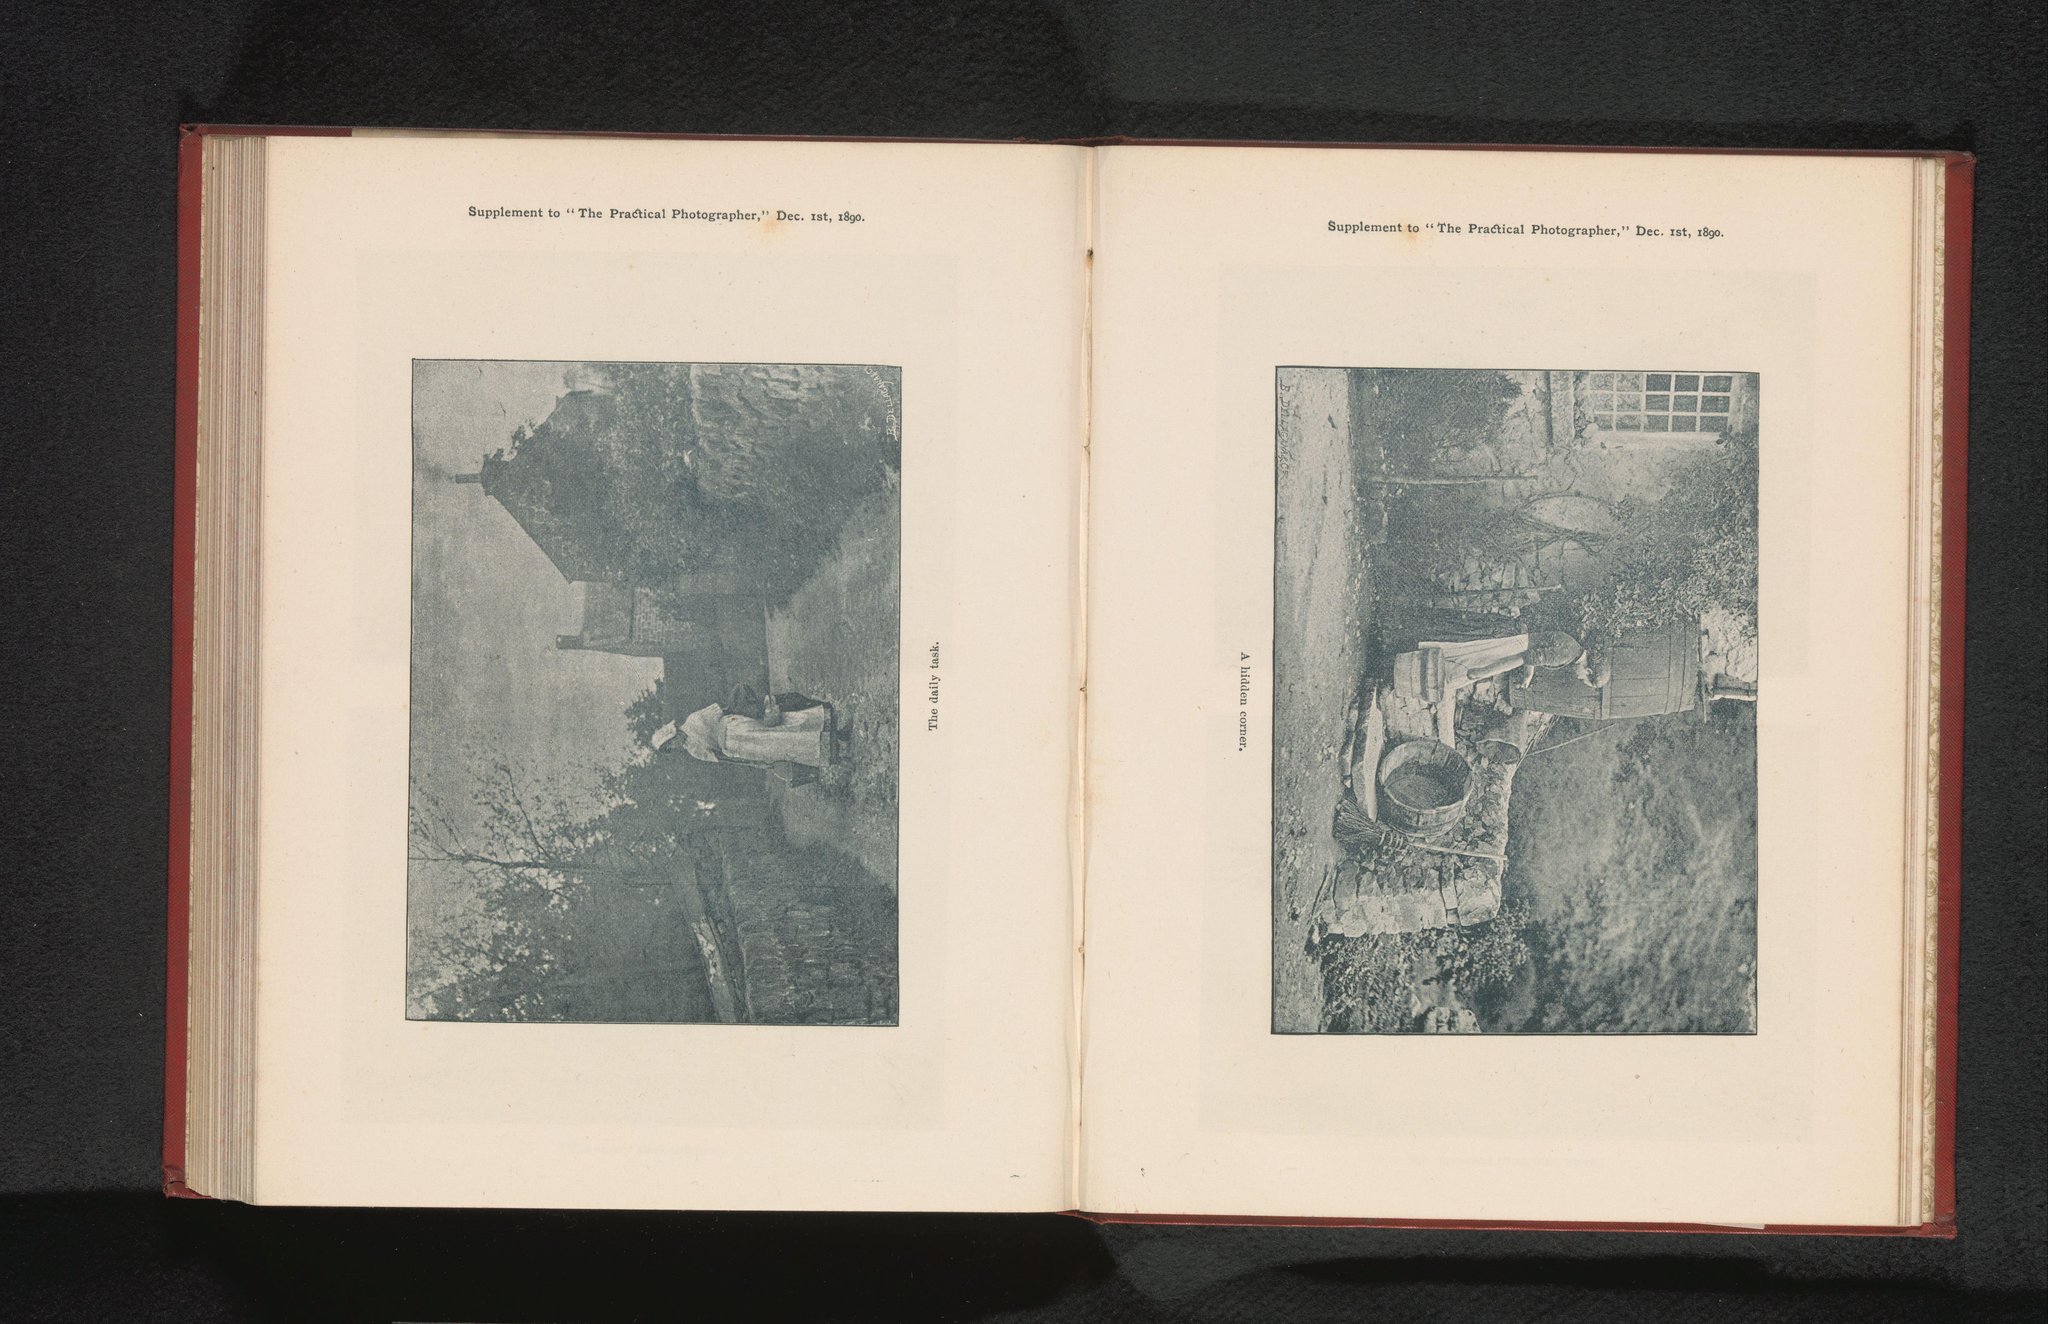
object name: photomechanical print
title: Vrouw met een emmer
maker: Anonymous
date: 1885-1890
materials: paper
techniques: autotype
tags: wooden container: barrel, cask, bucket, adult woman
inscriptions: inscription: ‘Supplement to "The Practical Photographer," Dec. 1st, 1890.’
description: Prent op zesde ongenummerde pagina na pagina 294.